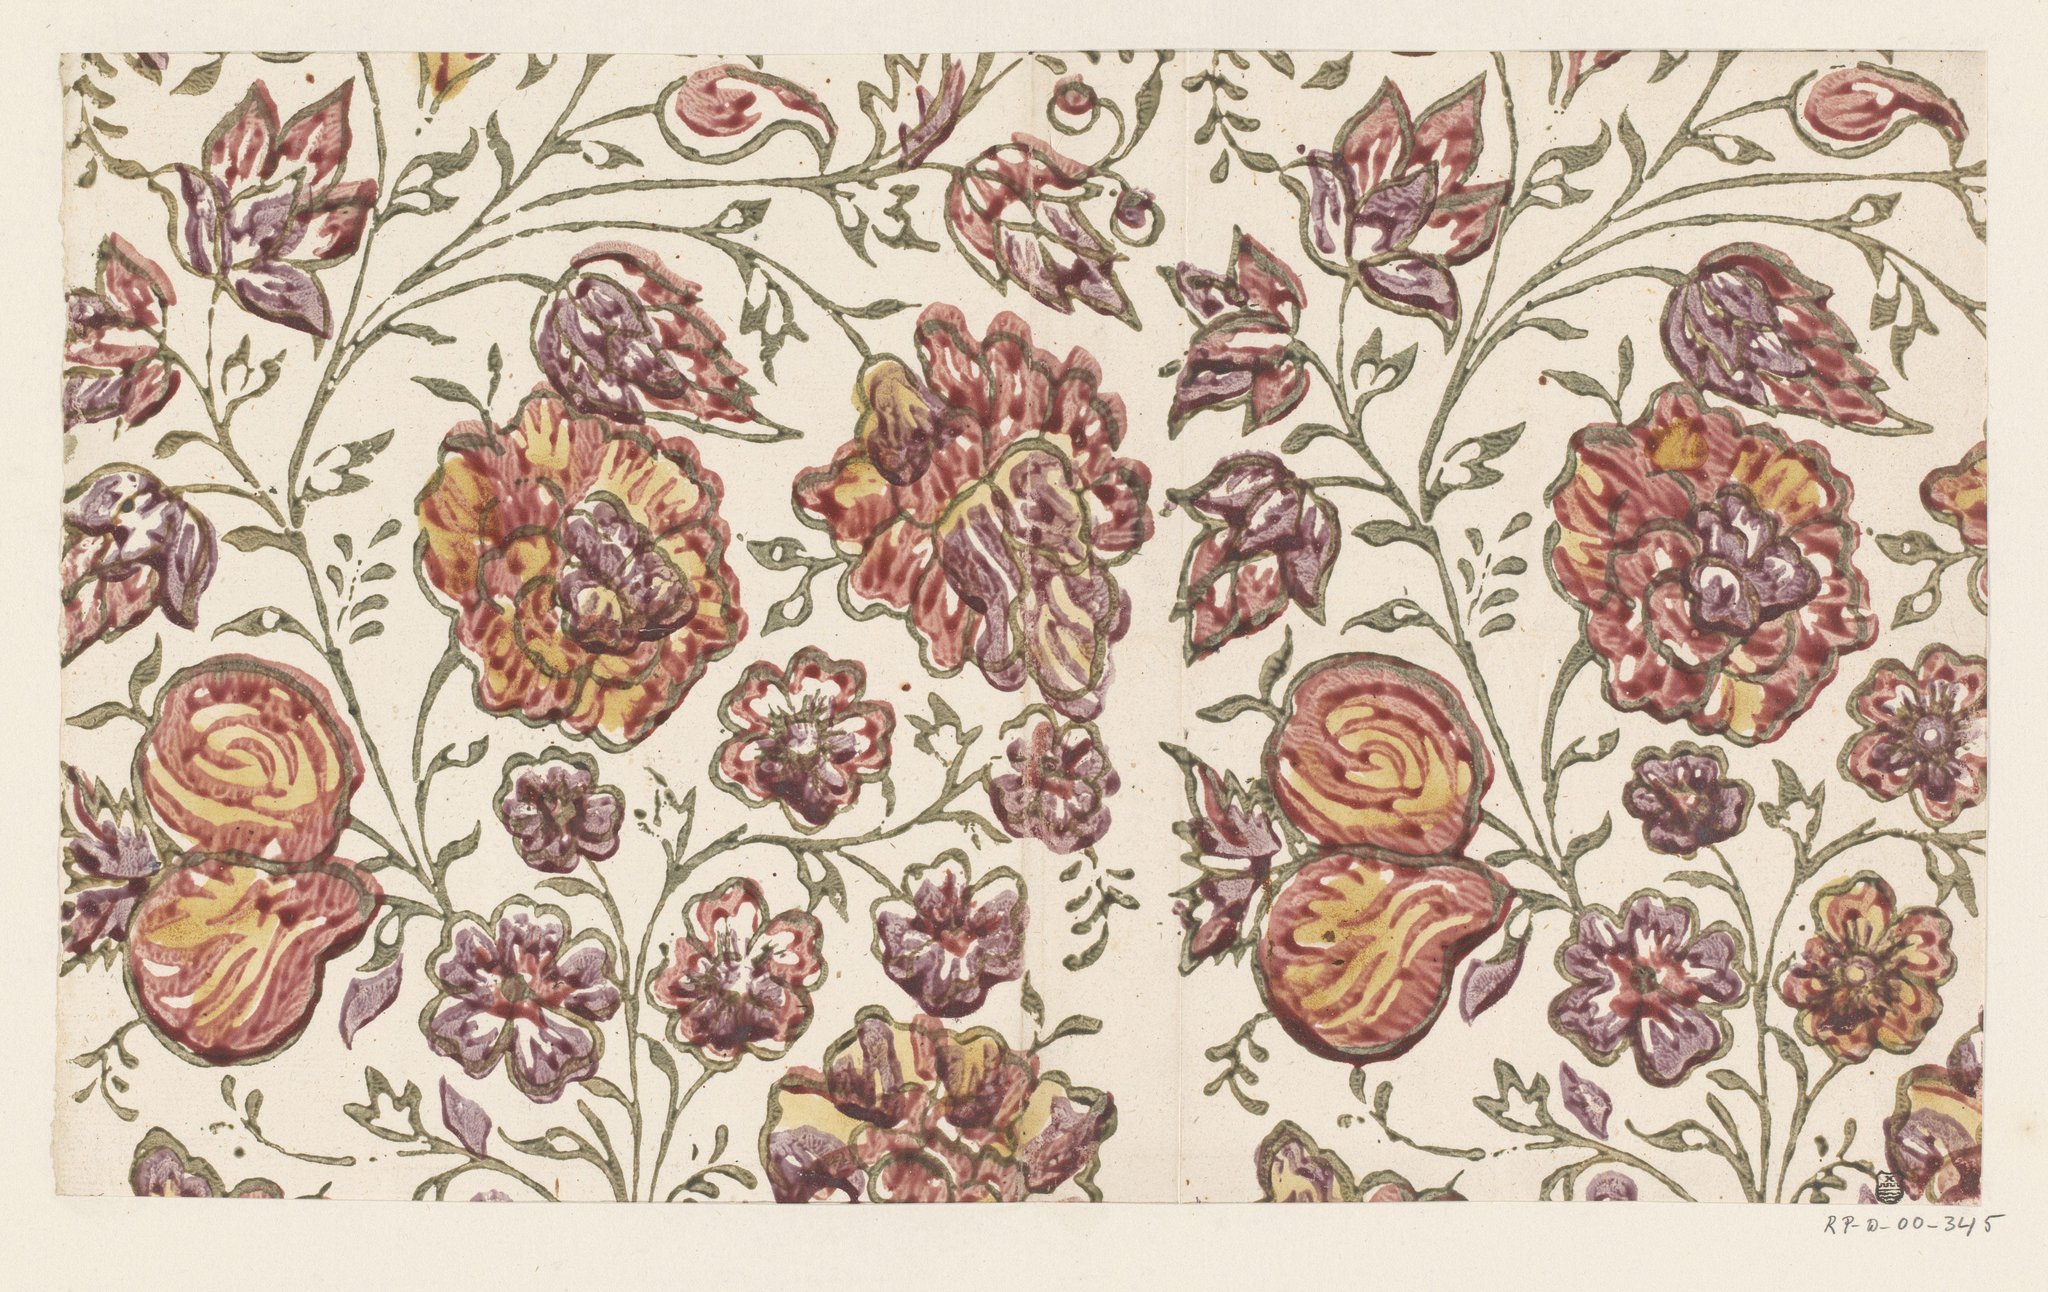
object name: printed paper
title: Blad met rank met bloemen en vruchten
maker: Anonymous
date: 1700-1850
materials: paper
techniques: printing block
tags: ornament derived from plant forms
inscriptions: collector's mark: Lugt 2760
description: Blad met rank met bloemen en vruchten. Mogelijk gebruikt als omslag.